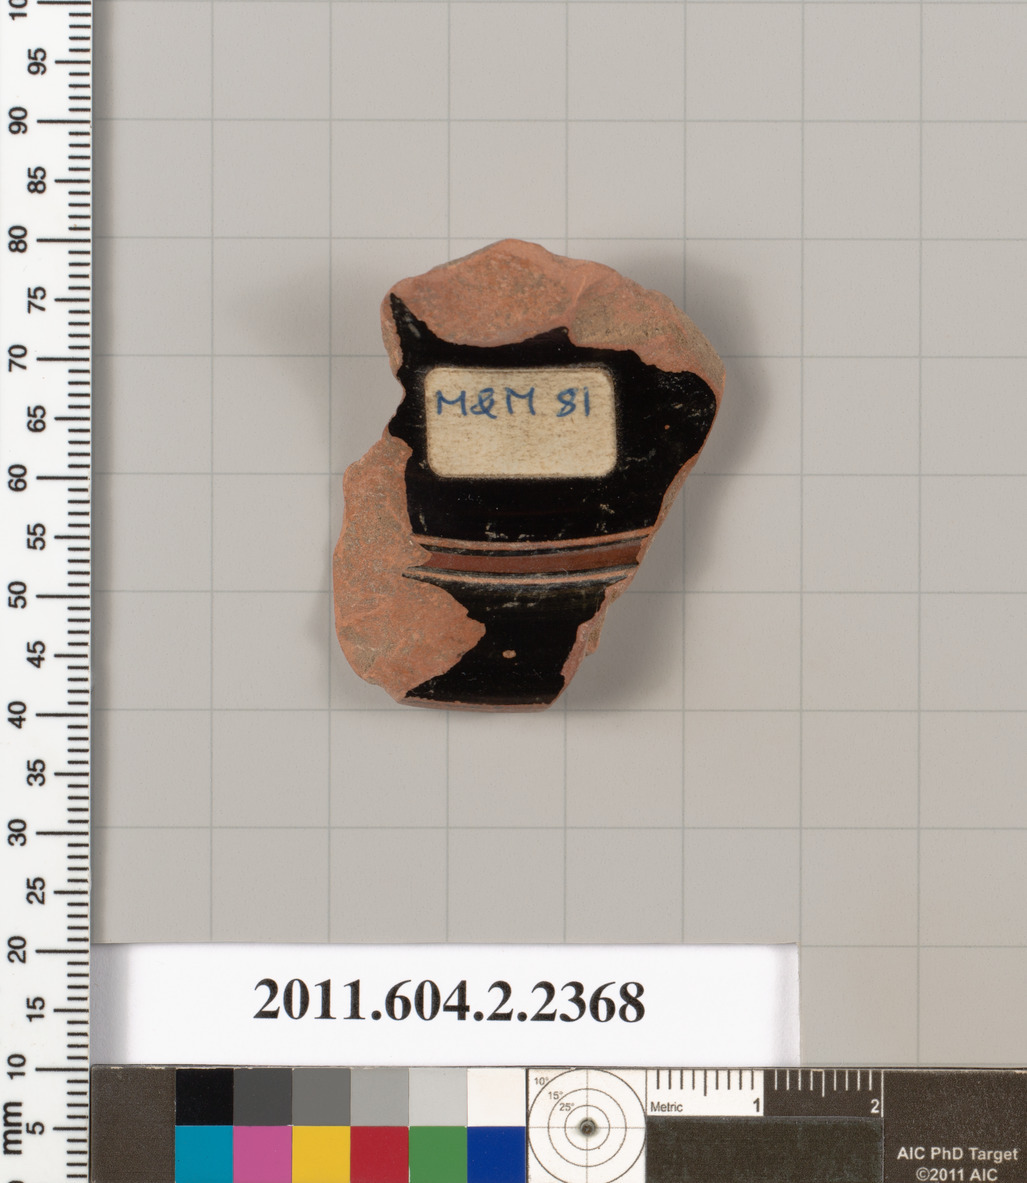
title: Terracotta fragment of an undetermined shape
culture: greek, attic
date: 534-468 BCE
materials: terracotta